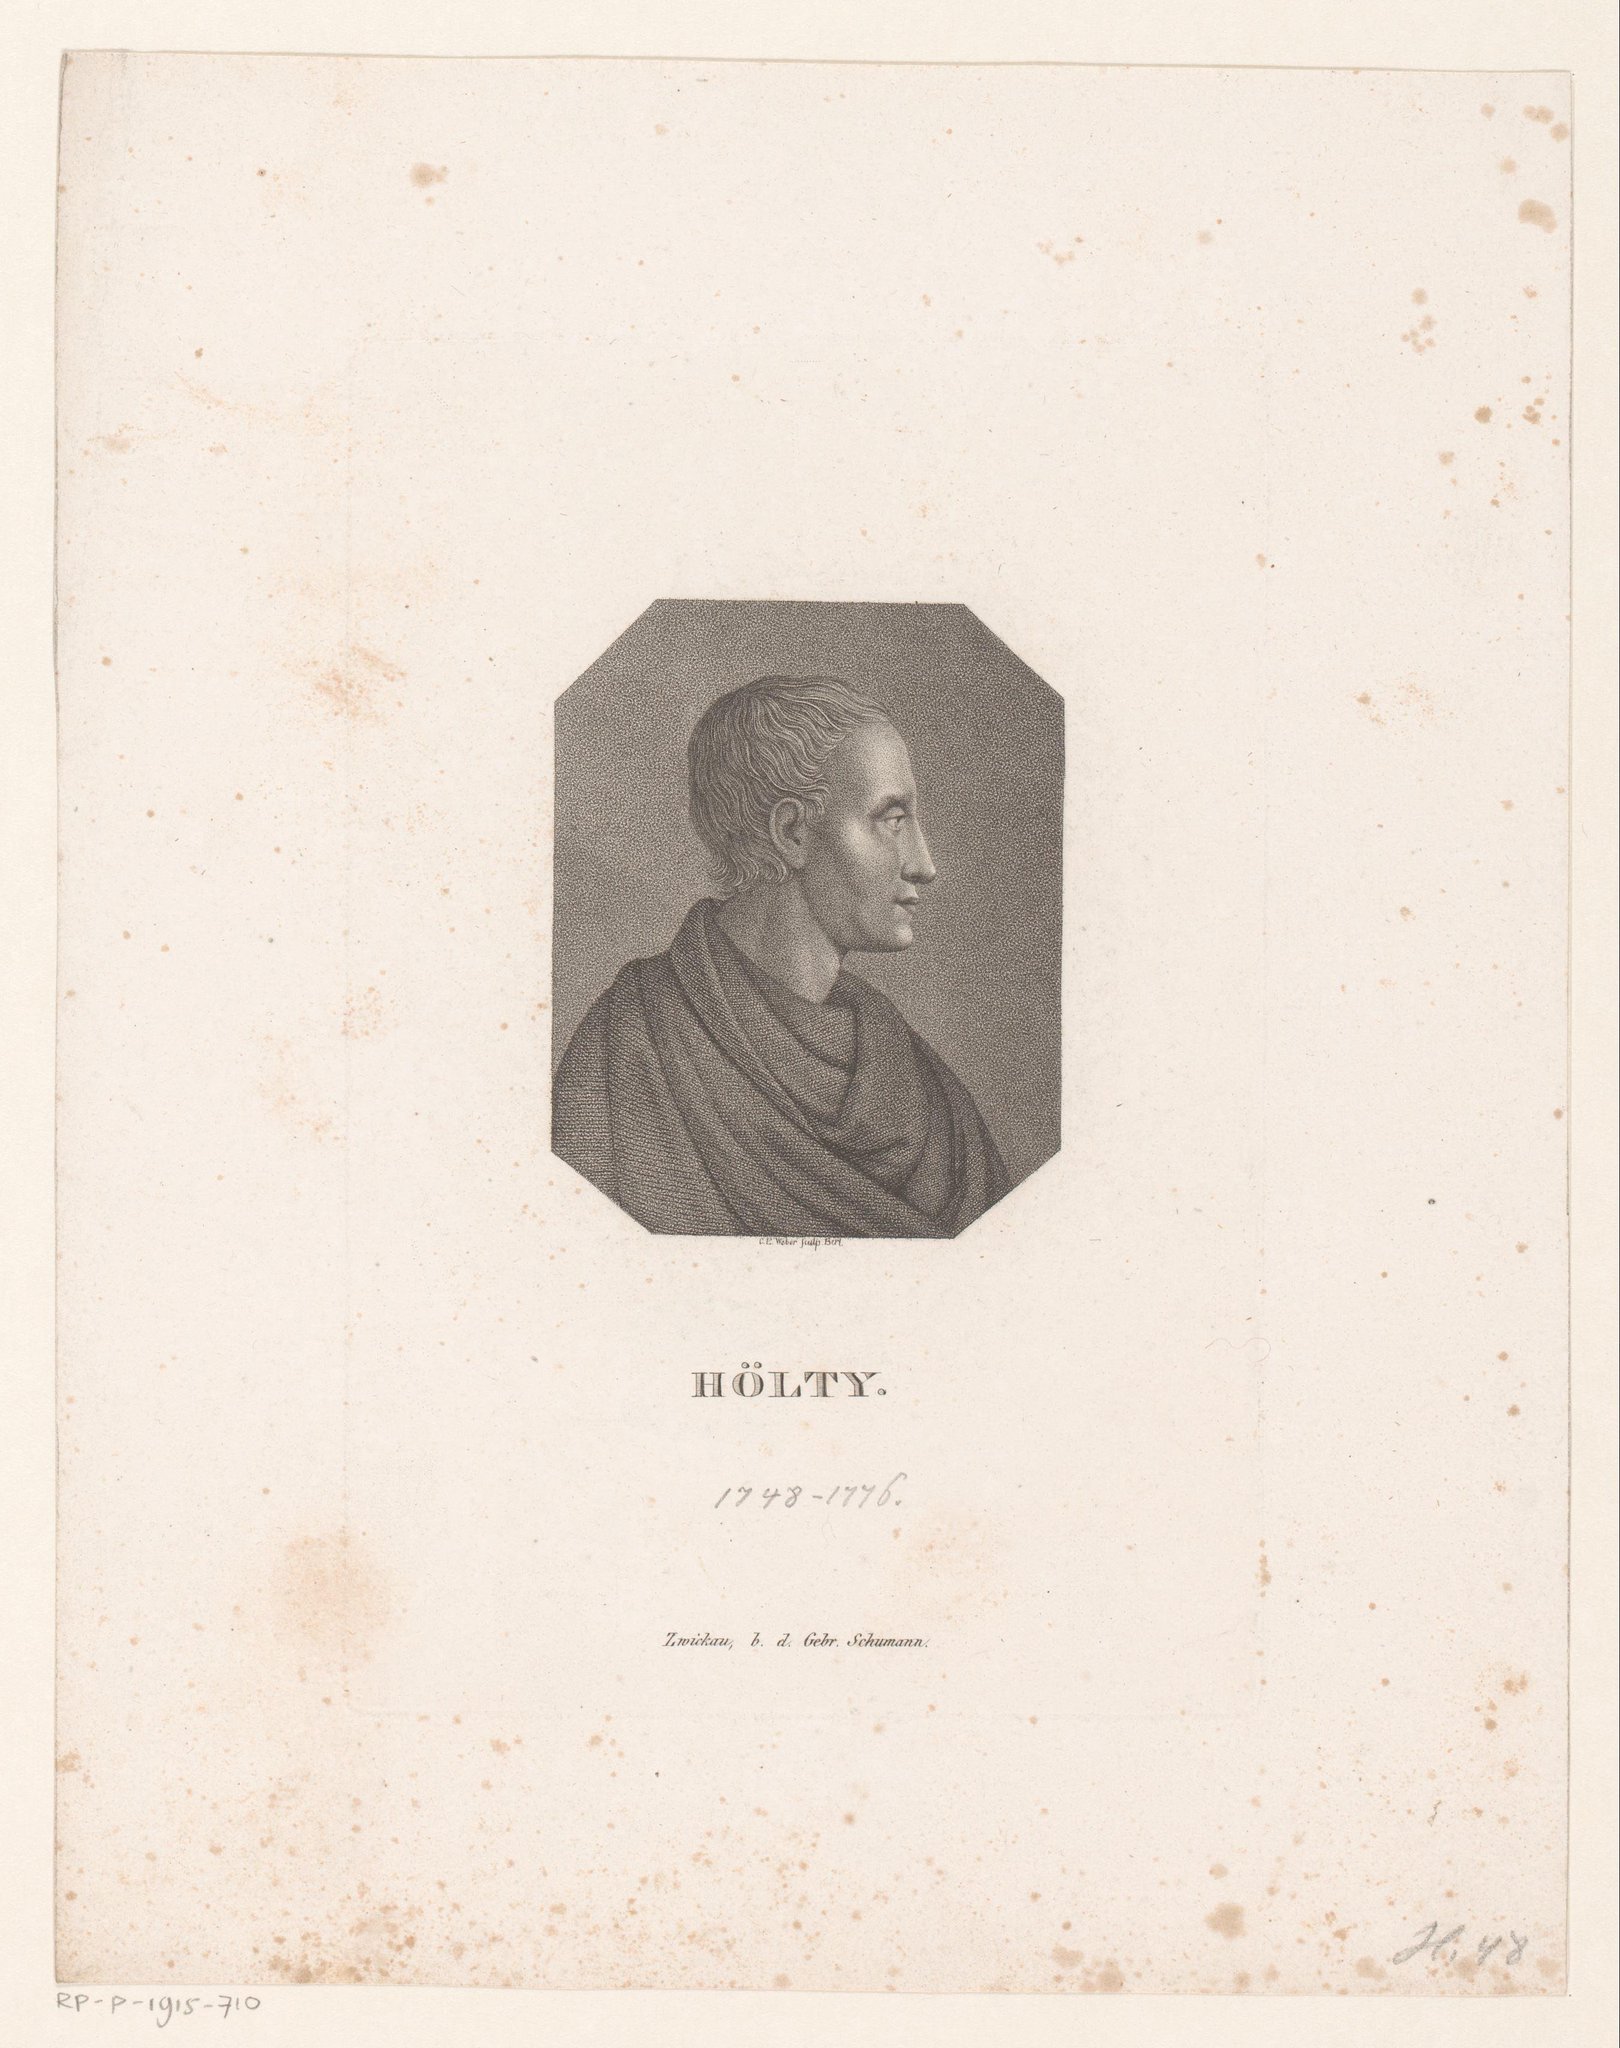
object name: print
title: Portret van Ludwig Hölty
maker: karl eduard weber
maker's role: draughtsman, painter, print maker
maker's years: 1806-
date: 1816-1832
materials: paper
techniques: stippling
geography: zwickau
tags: historical persons, writer, poet, author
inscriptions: collector's mark: Lugt 2228